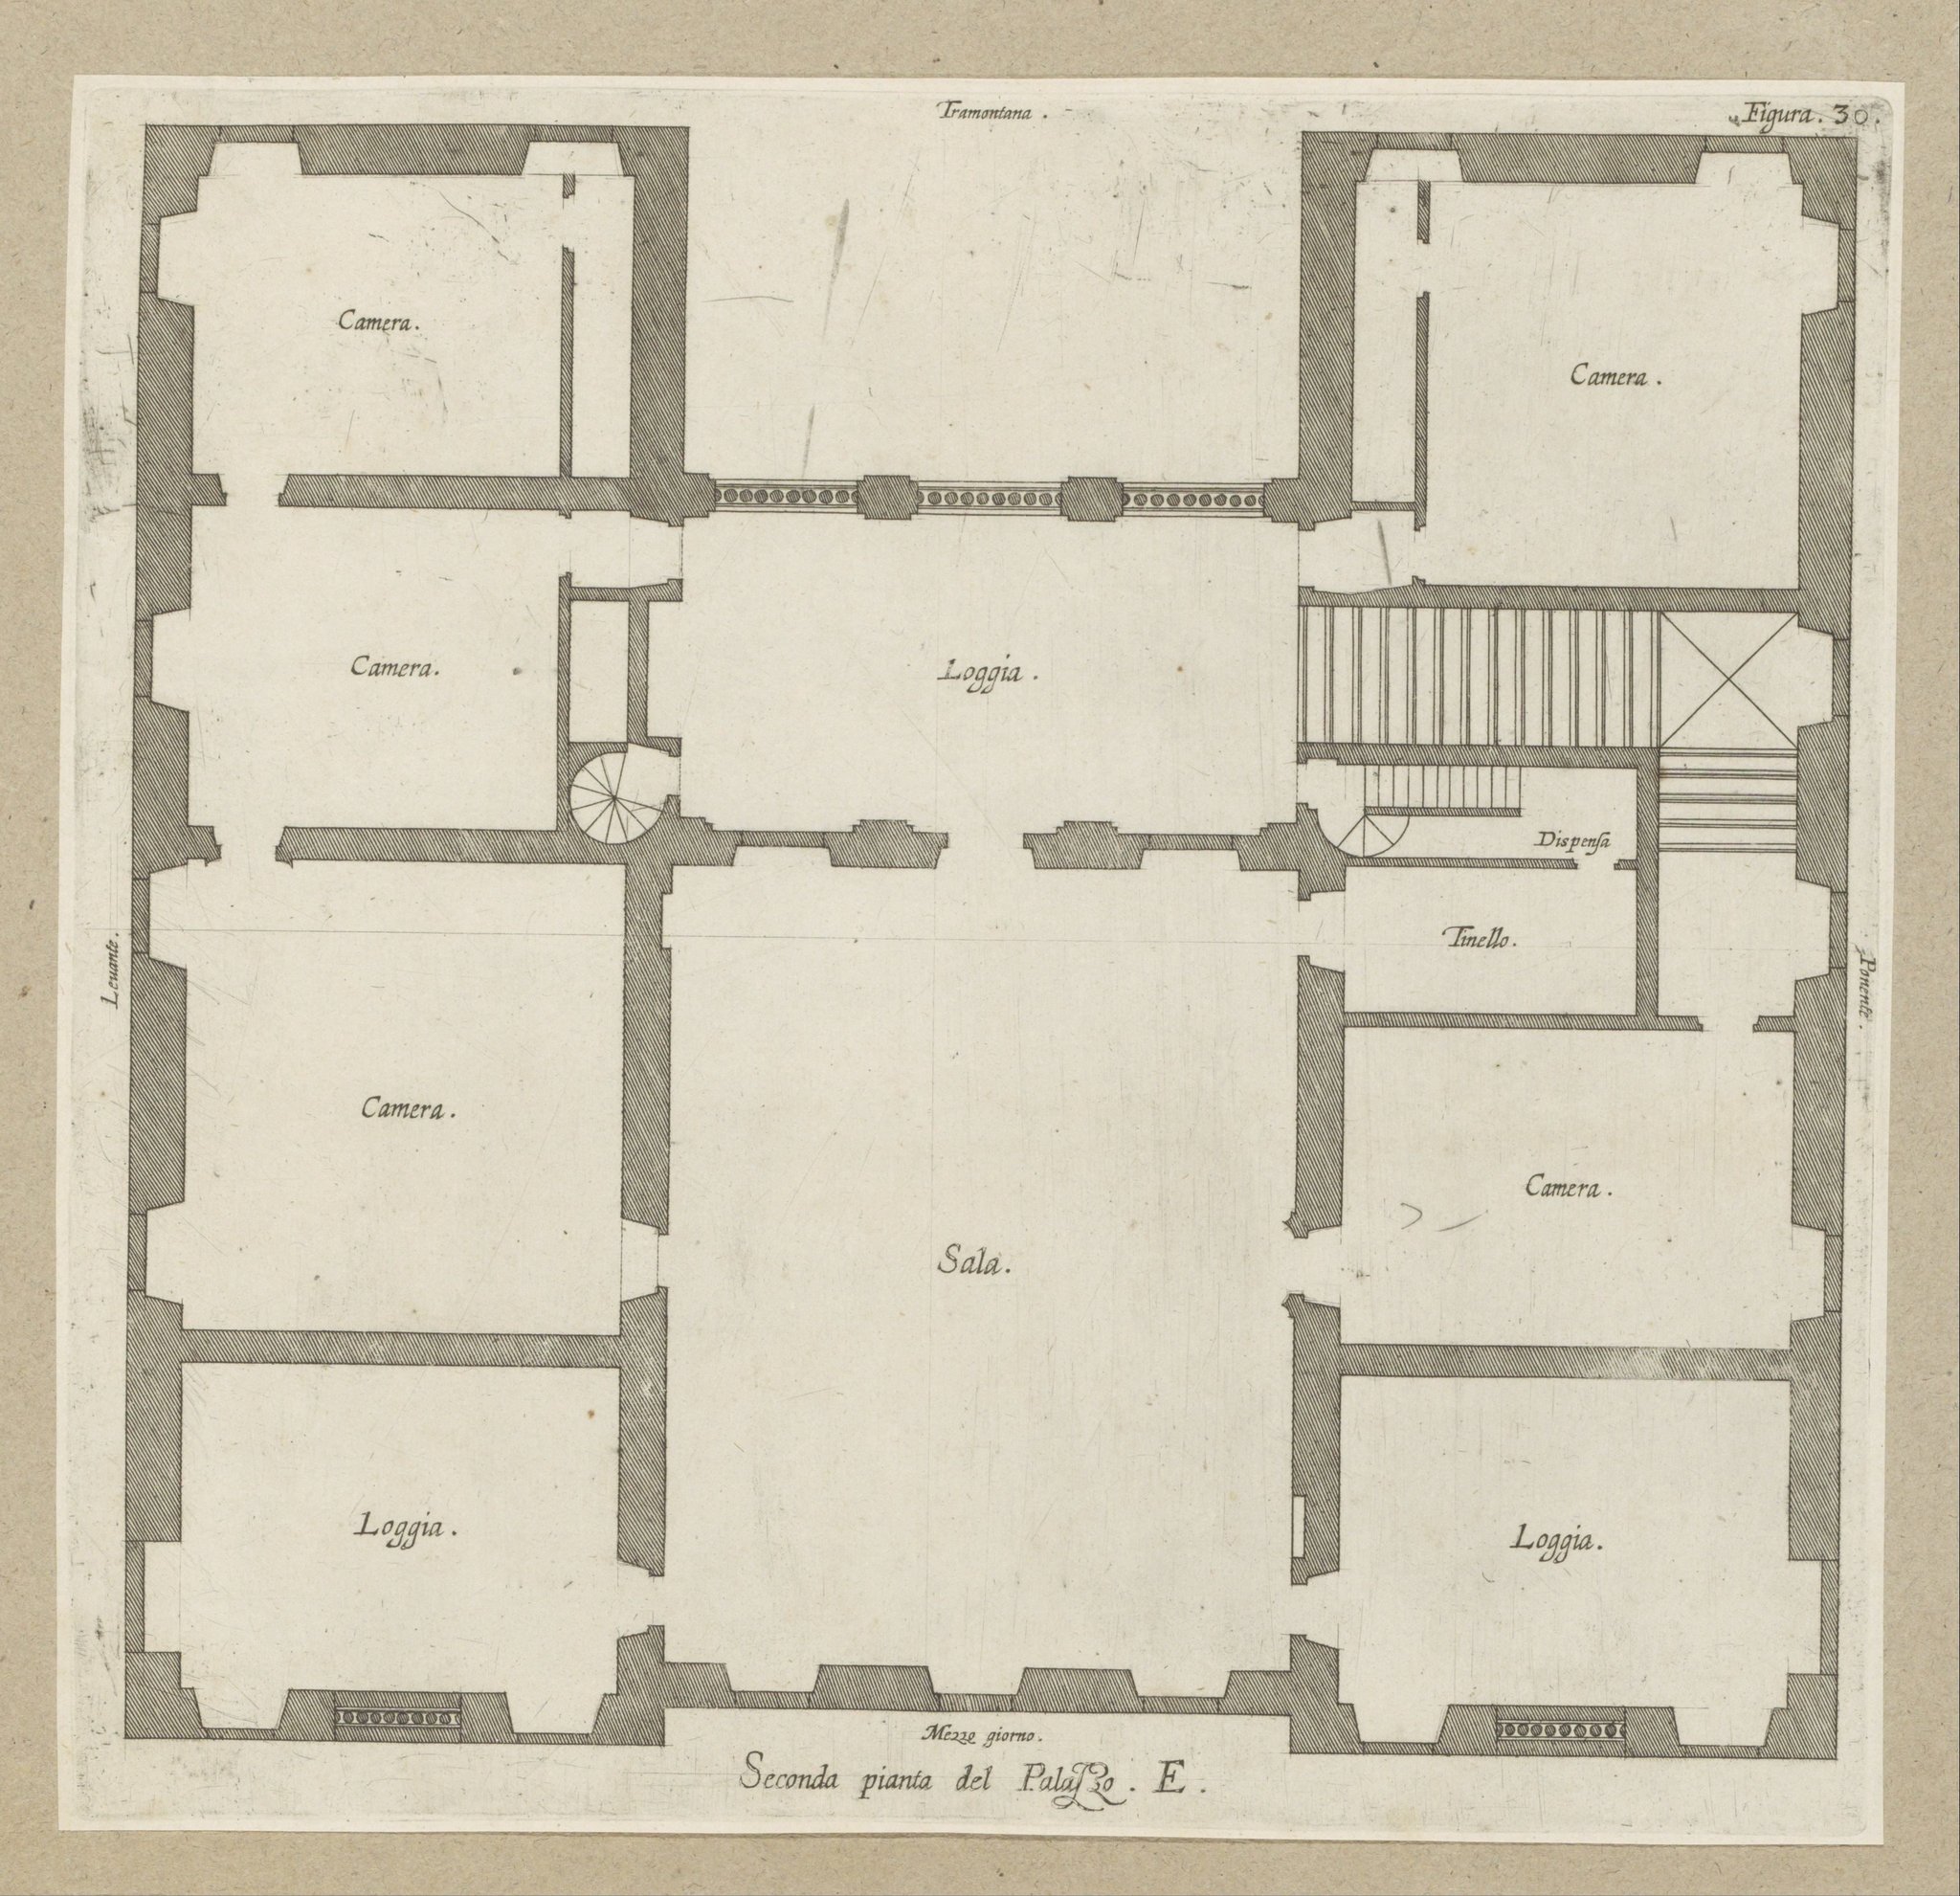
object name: album leaf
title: Plattegrond van de eerste verdieping van de villa Pallavicino delle Peschiere te Genua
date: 1622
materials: paper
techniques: engraving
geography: antwerp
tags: hôtel, i.e. small palace in city - aa - civic architecture: inside, plan ~ architecture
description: Deze prent maakt deel uit van een album.